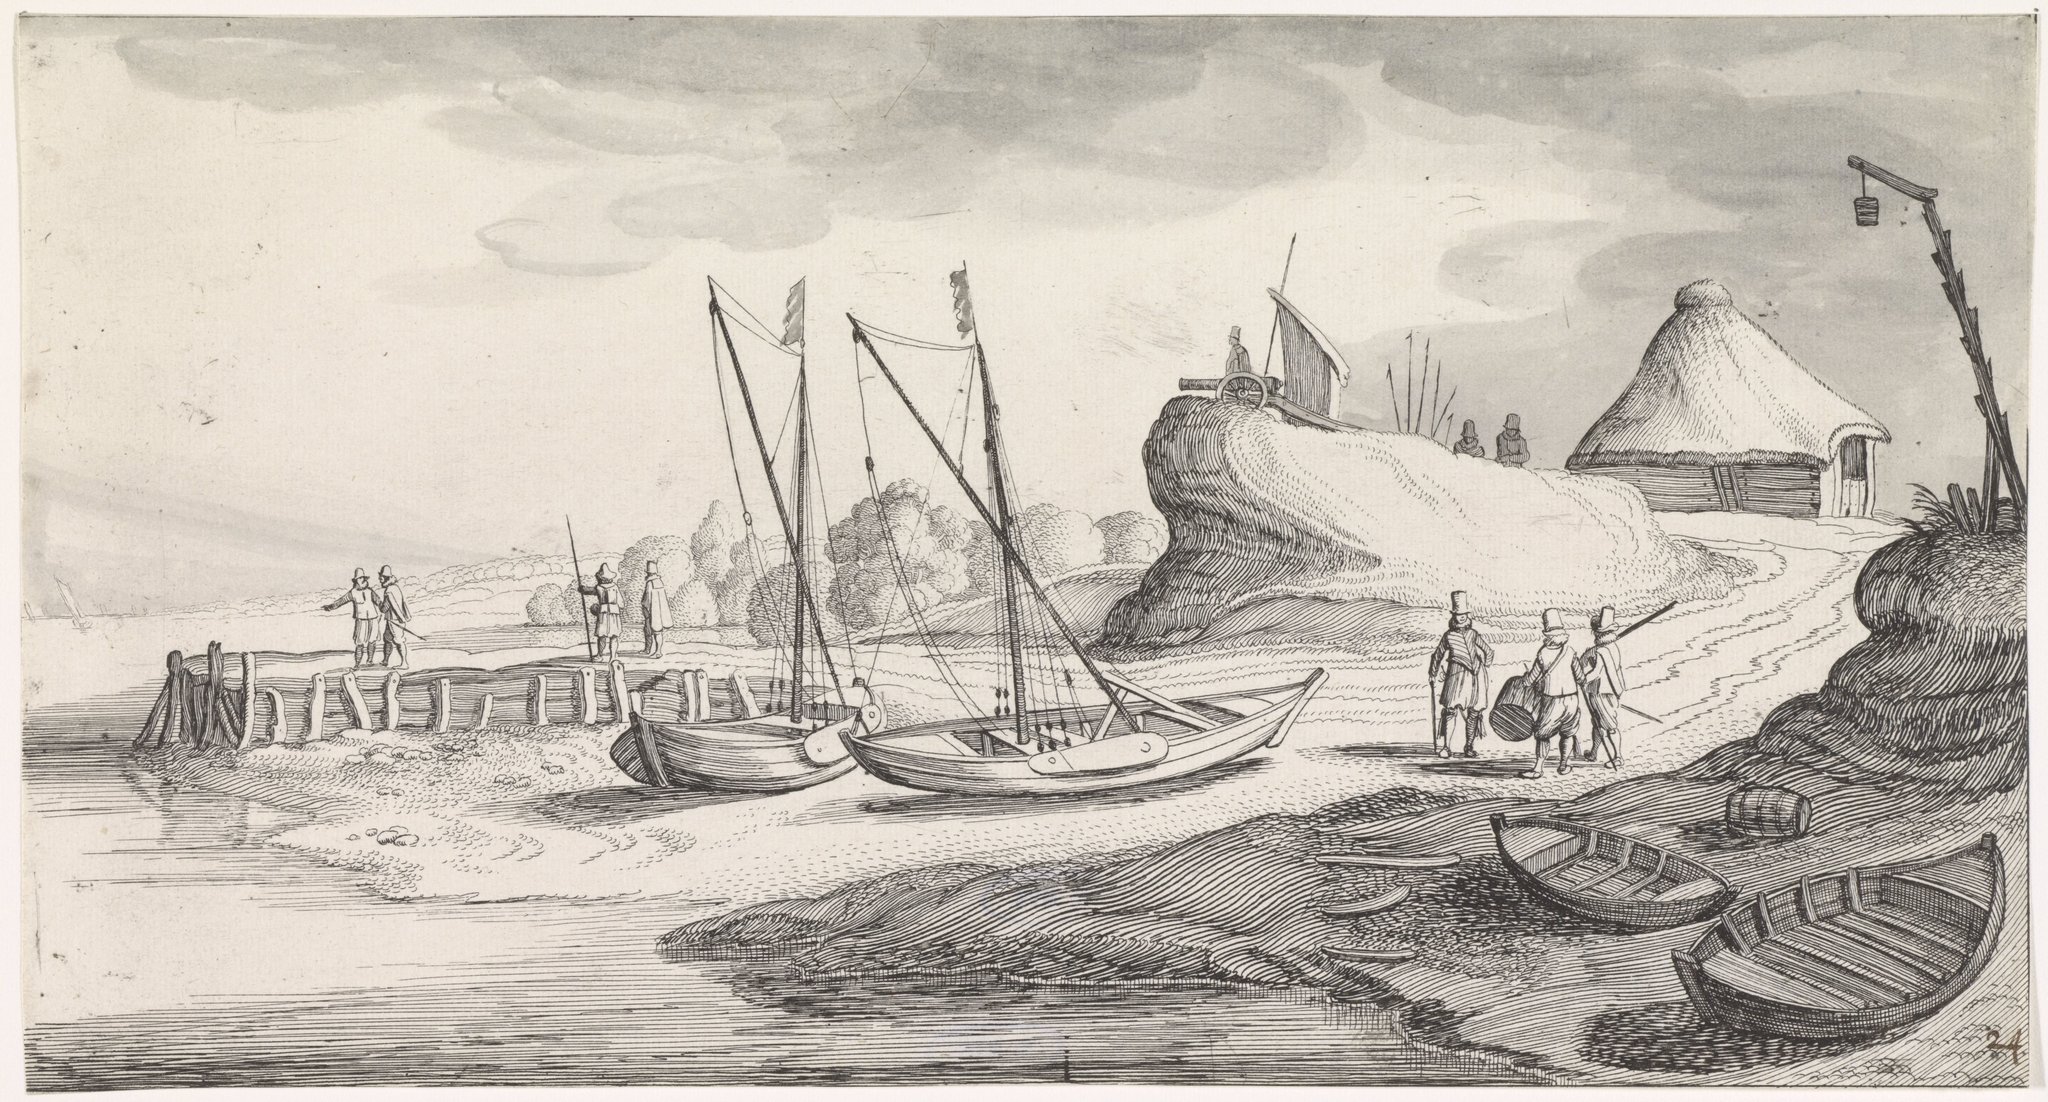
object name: print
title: Boten op een rivieroever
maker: jan van de velde (ii)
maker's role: draughtsman, painter, print maker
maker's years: 1593-1641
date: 1639-1641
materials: ink, paper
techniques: brush, etching, pen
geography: northern netherlands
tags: sailing-ship, sailing-boat, river bank, firearms: cannon, the soldier; the soldier's life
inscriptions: collector's mark: Lugt 2228, number: ‘24’, collector's mark: Lugt 1120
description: Boten op een rivieroever en soldaten op wacht. 24ste prent van een serie met 36 prenten van landschappen, verdeeld over zes delen.